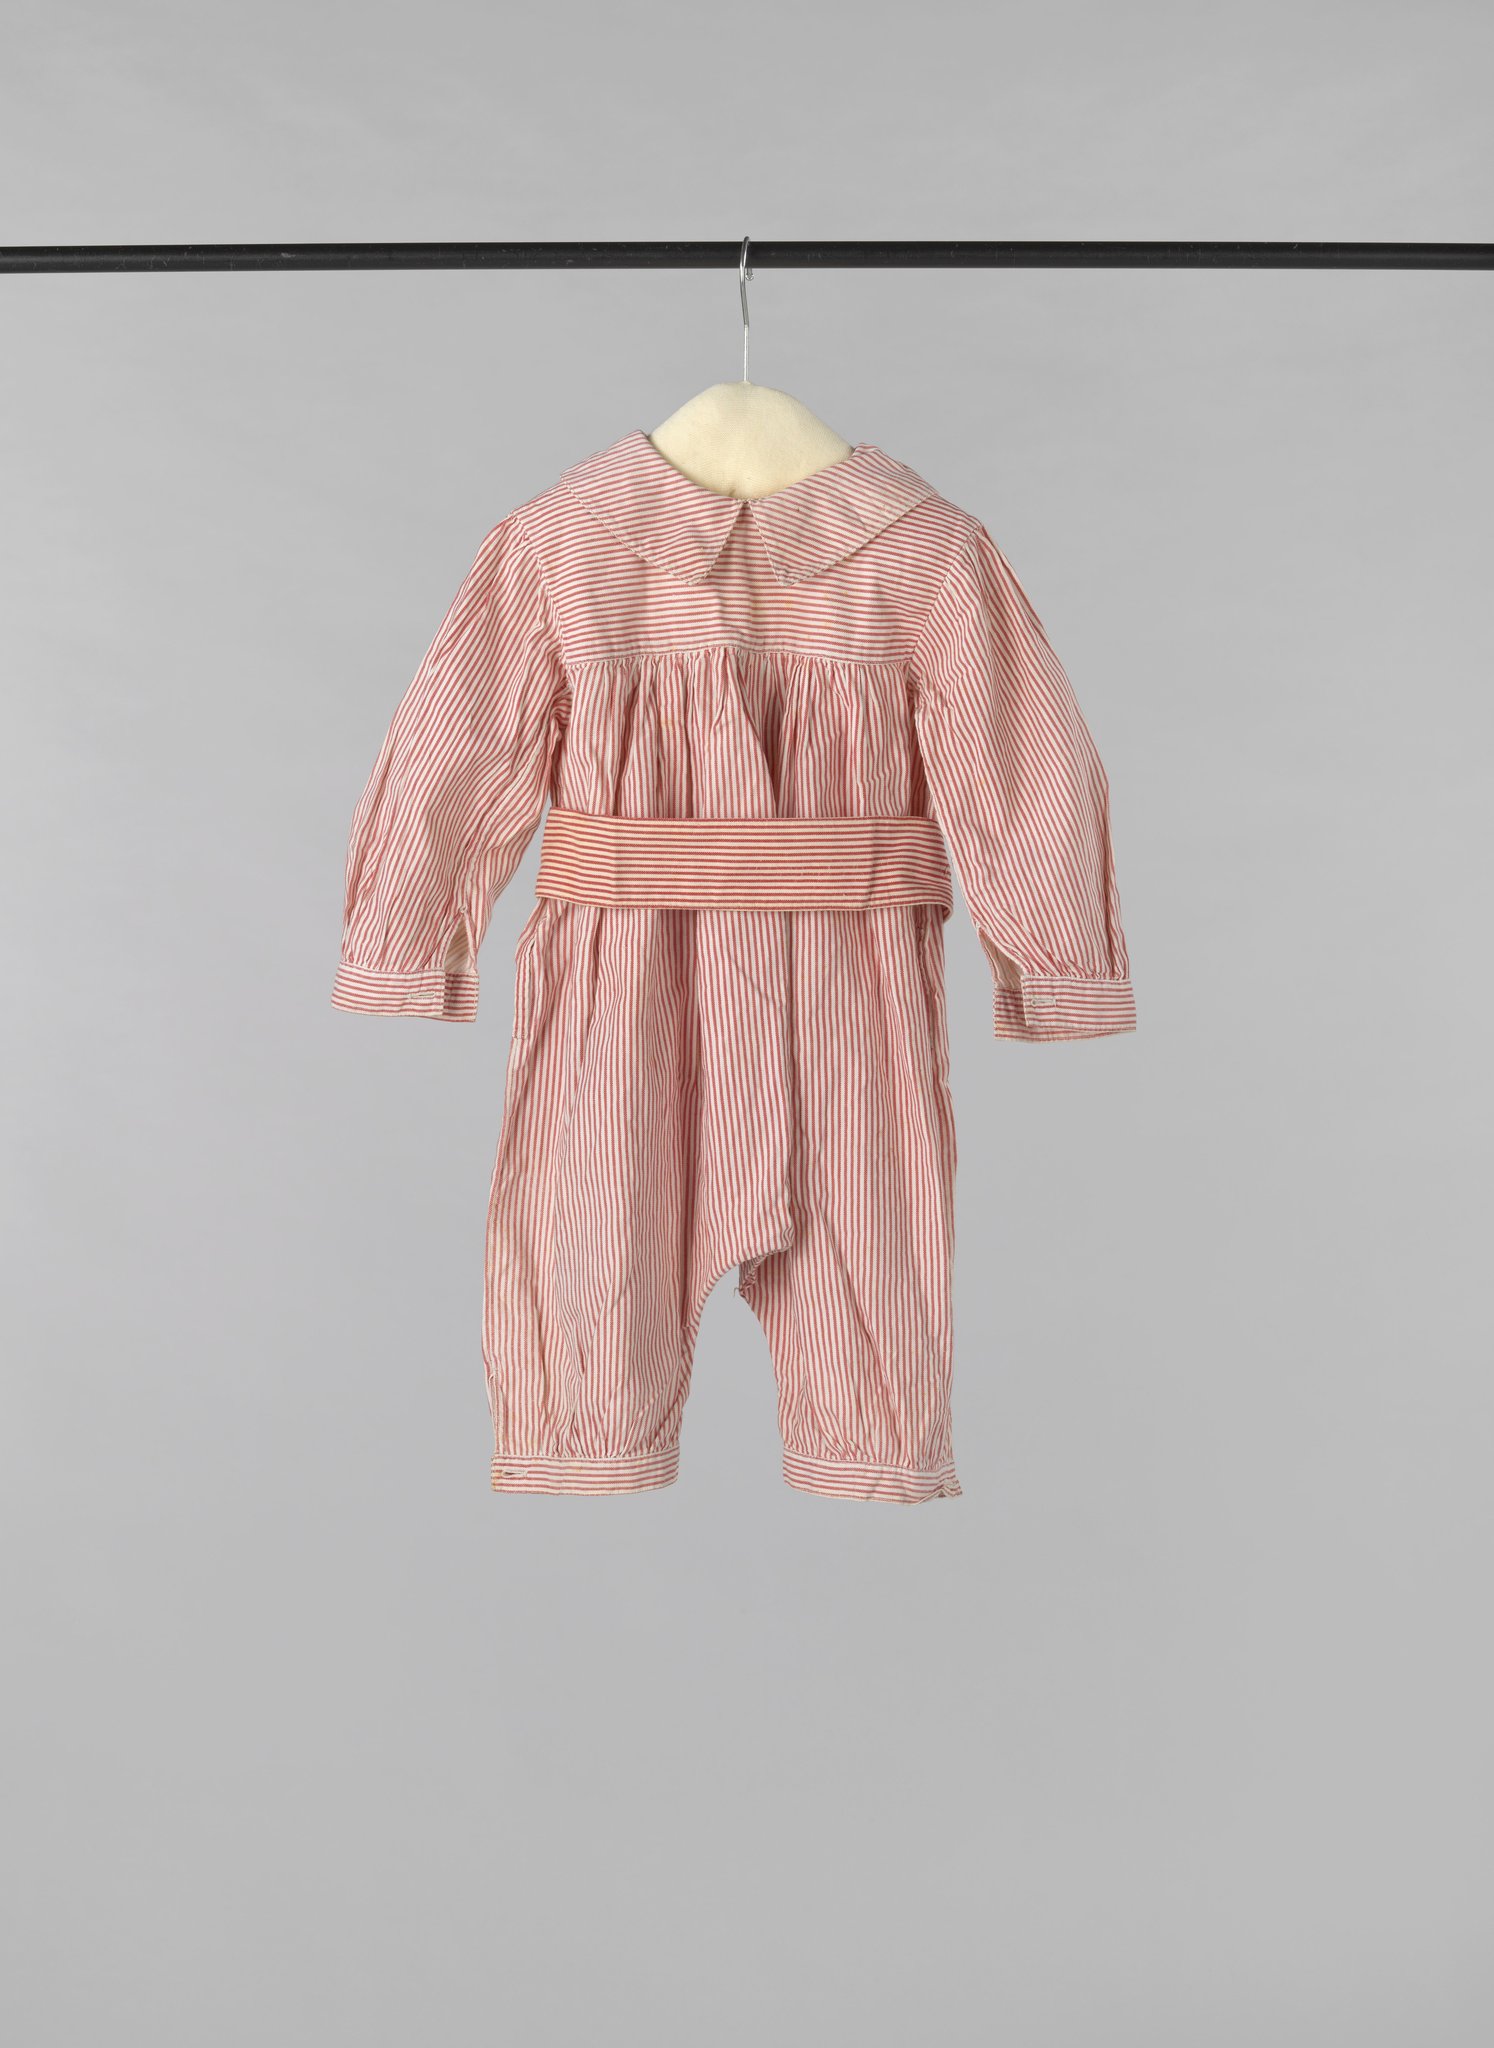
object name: belt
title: Ceintuur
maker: Anonymous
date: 1905-1910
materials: cotton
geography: malang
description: Ceintuur, behorend bij hansop BK-1993-24-a.